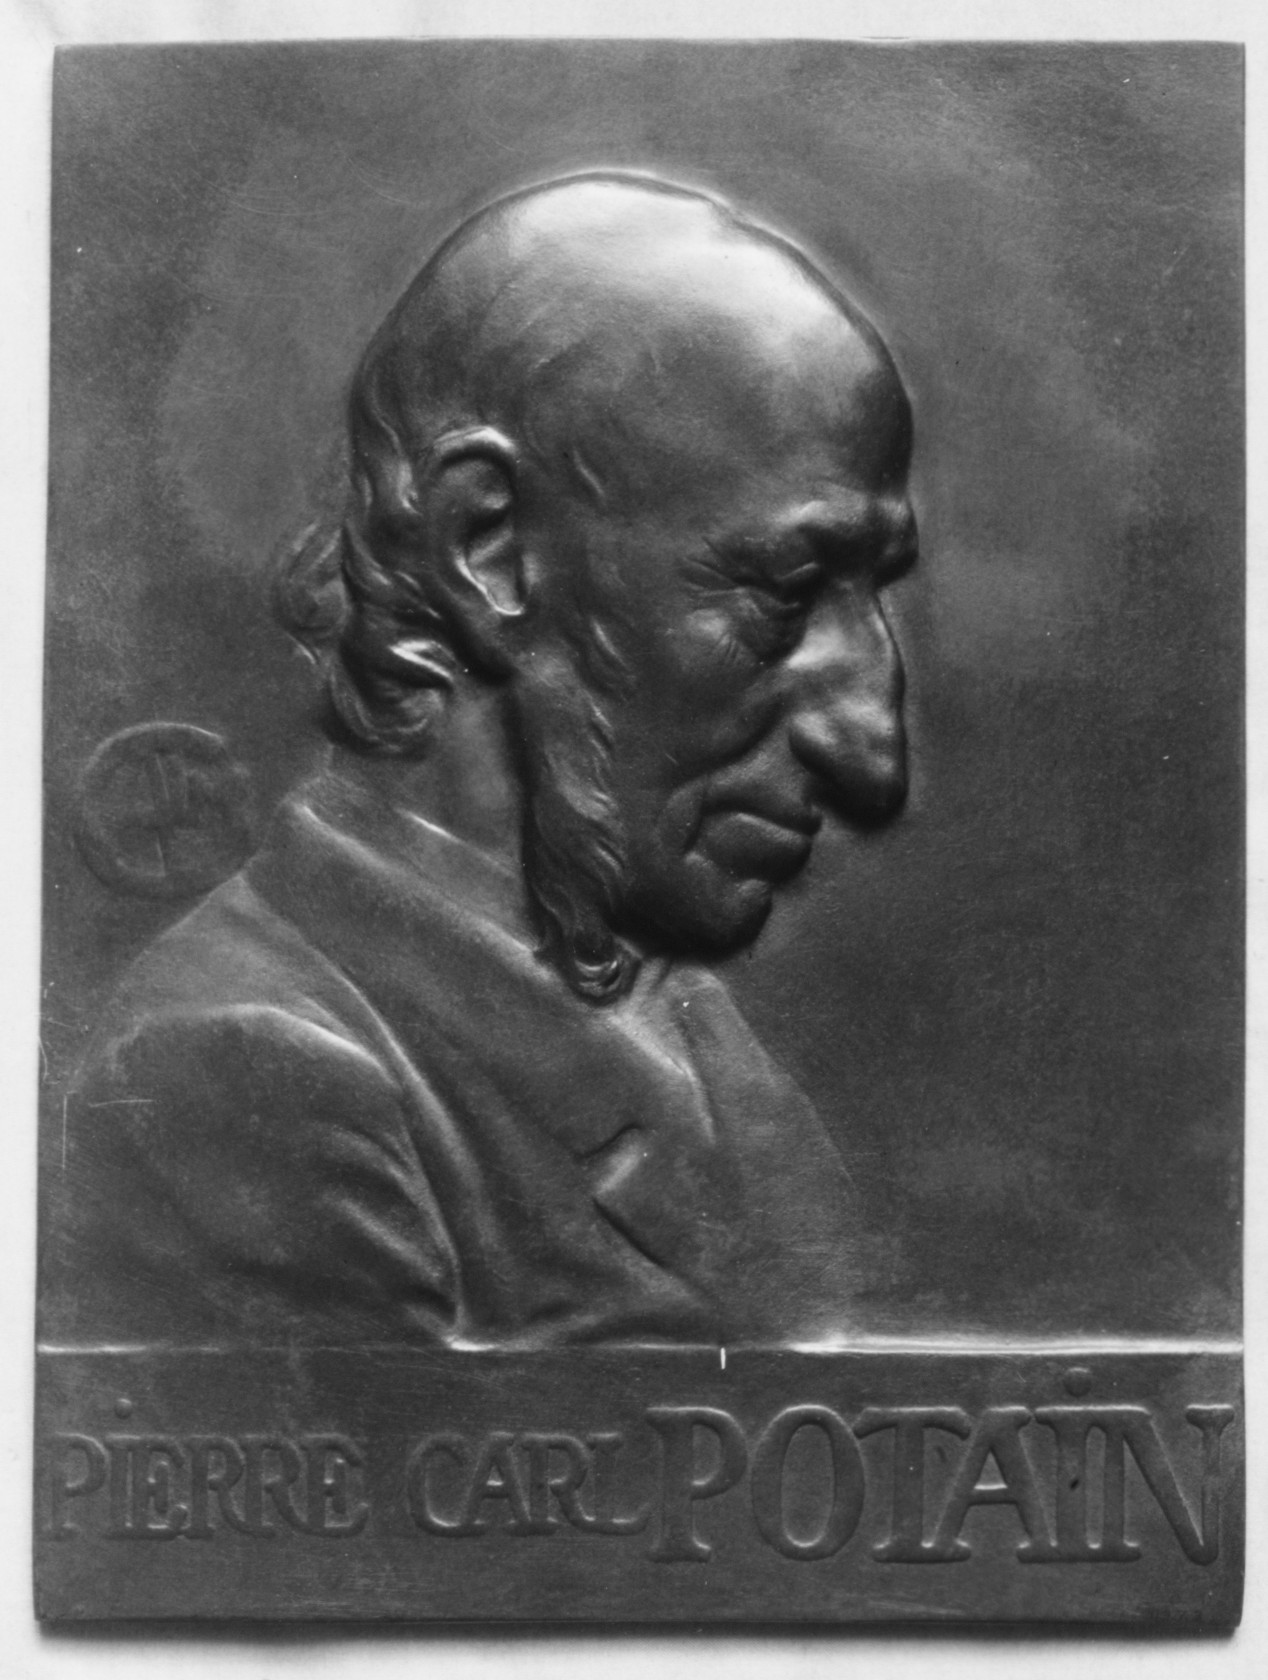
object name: plaque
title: Doctor Pierre Carl Potain (1825–1901)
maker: alexandre-louis-marie charpentier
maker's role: artist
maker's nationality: french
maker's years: 1856-1909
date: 1901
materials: bronze, patina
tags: men,profiles,doctors